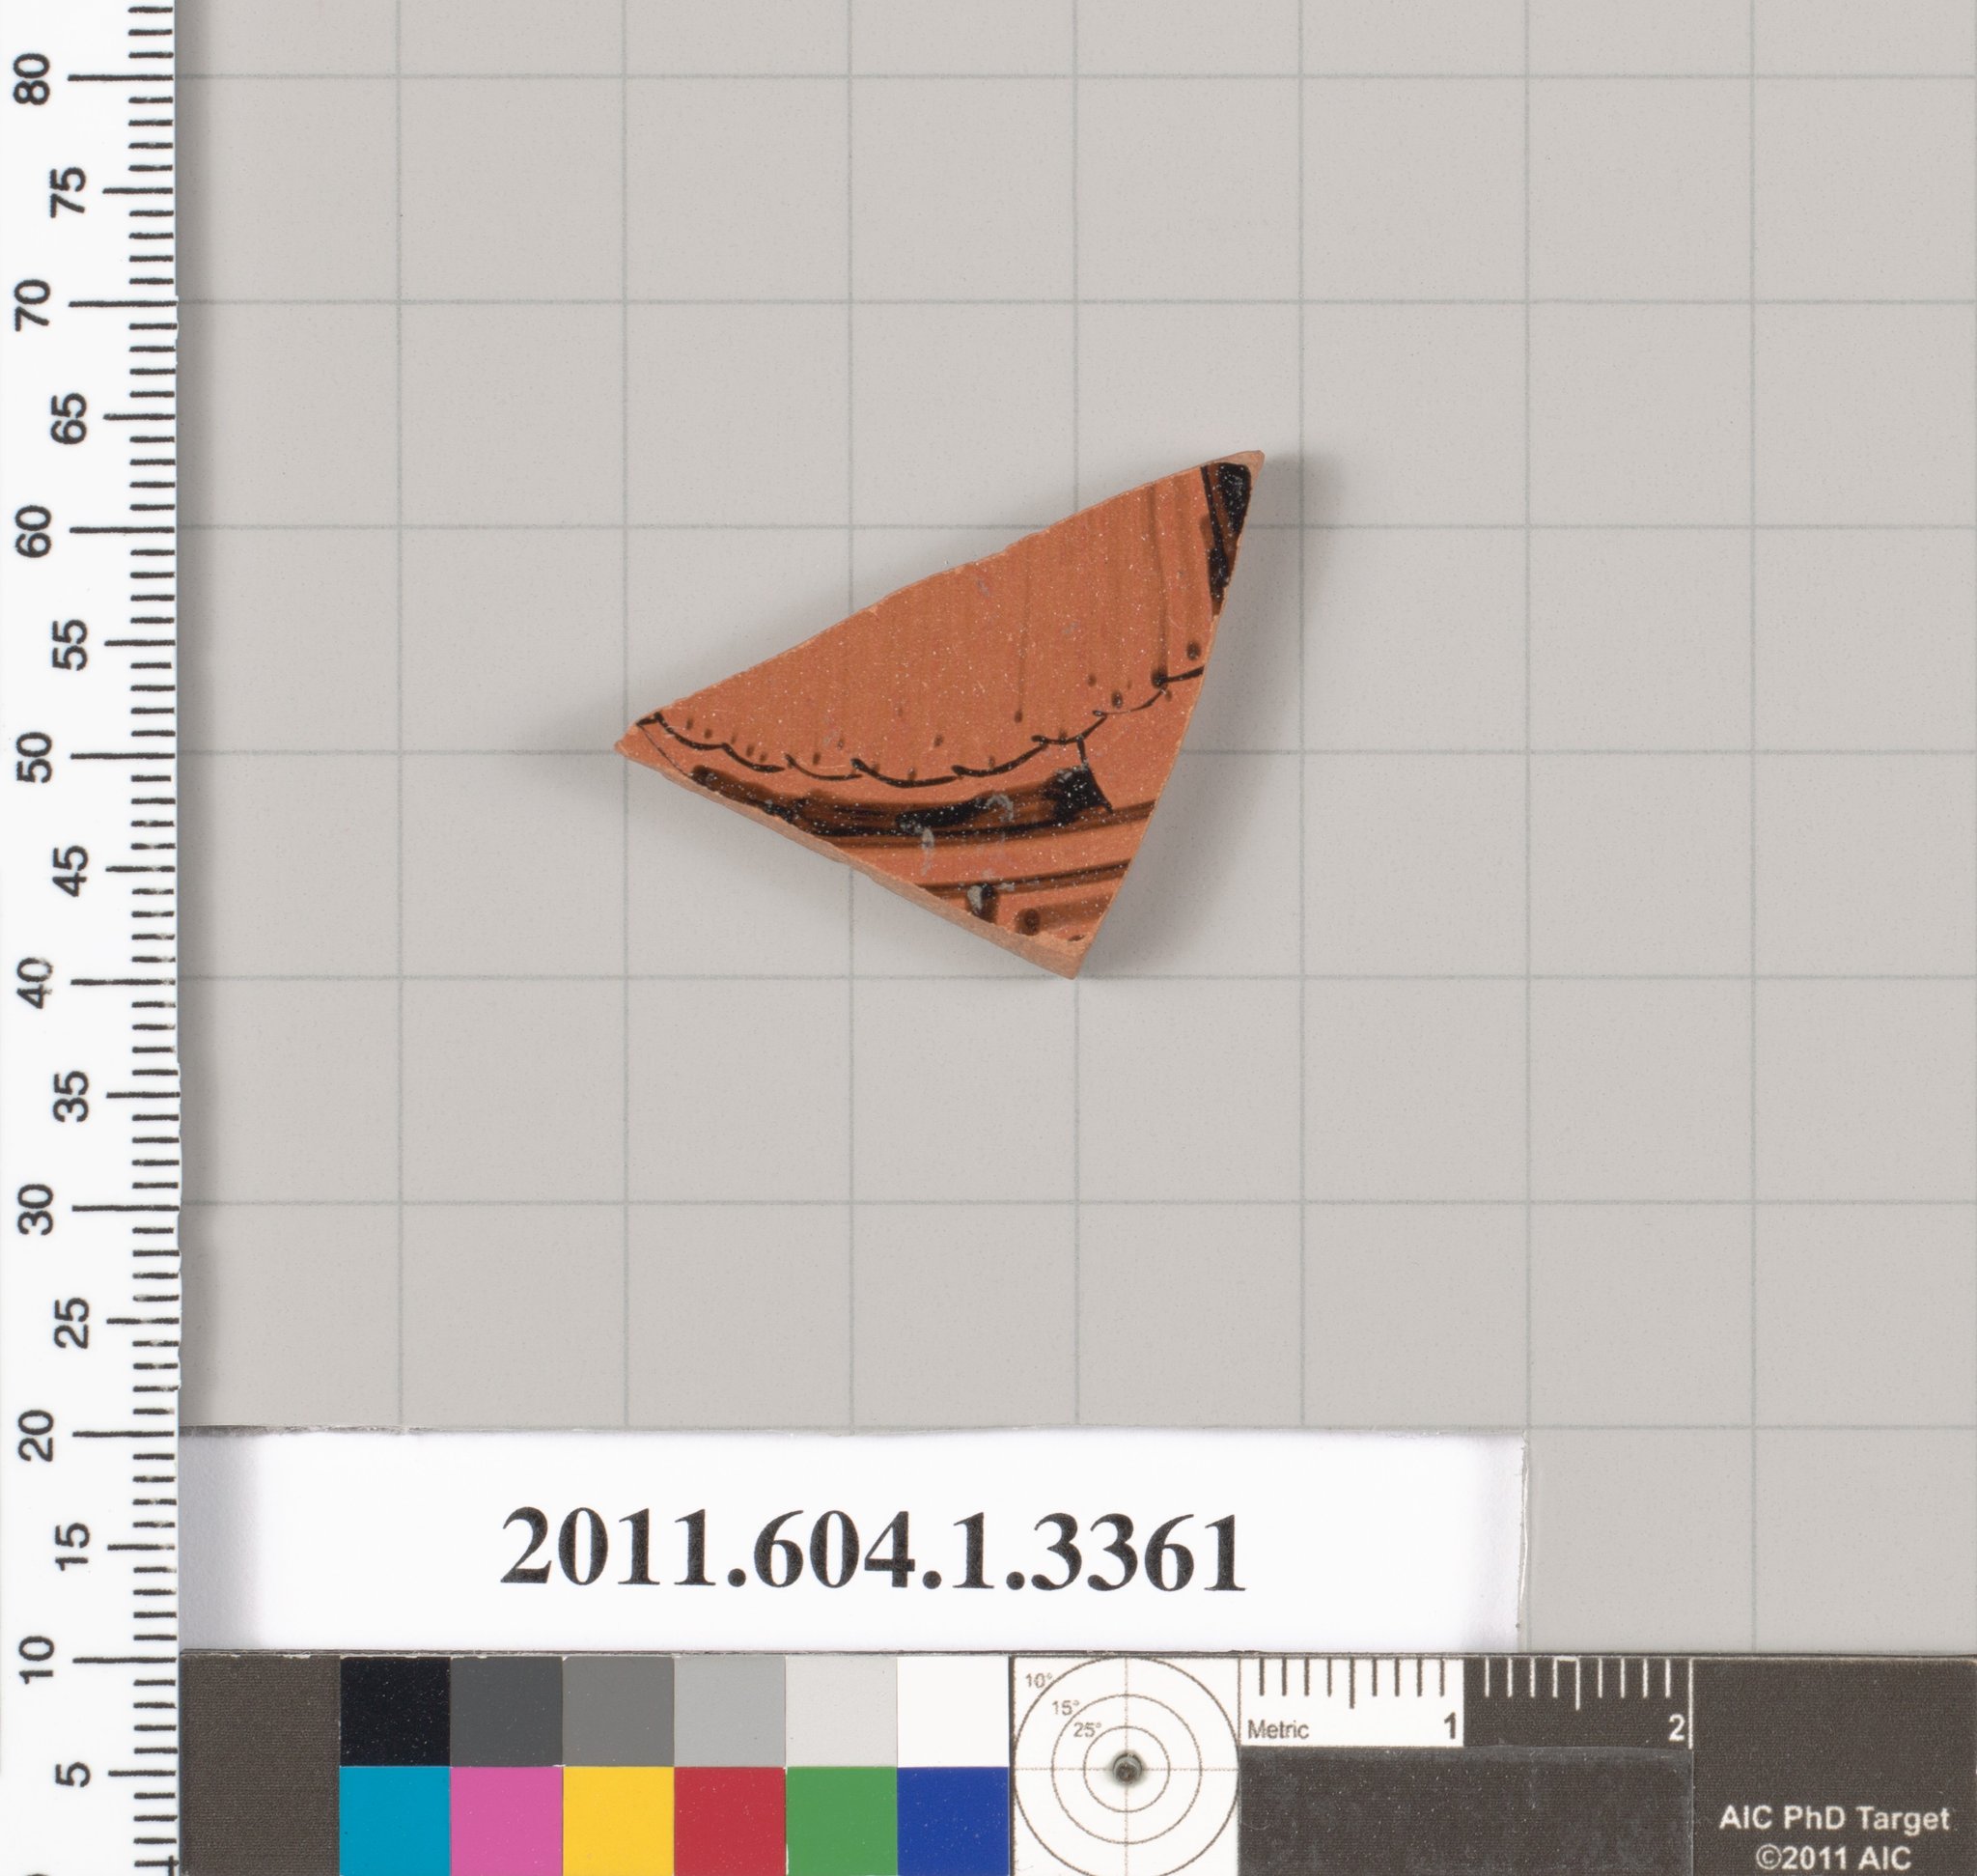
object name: kylix fragment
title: Terracotta fragment of a kylix (drinking cup)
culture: greek, attic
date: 475-451 BCE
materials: terracotta